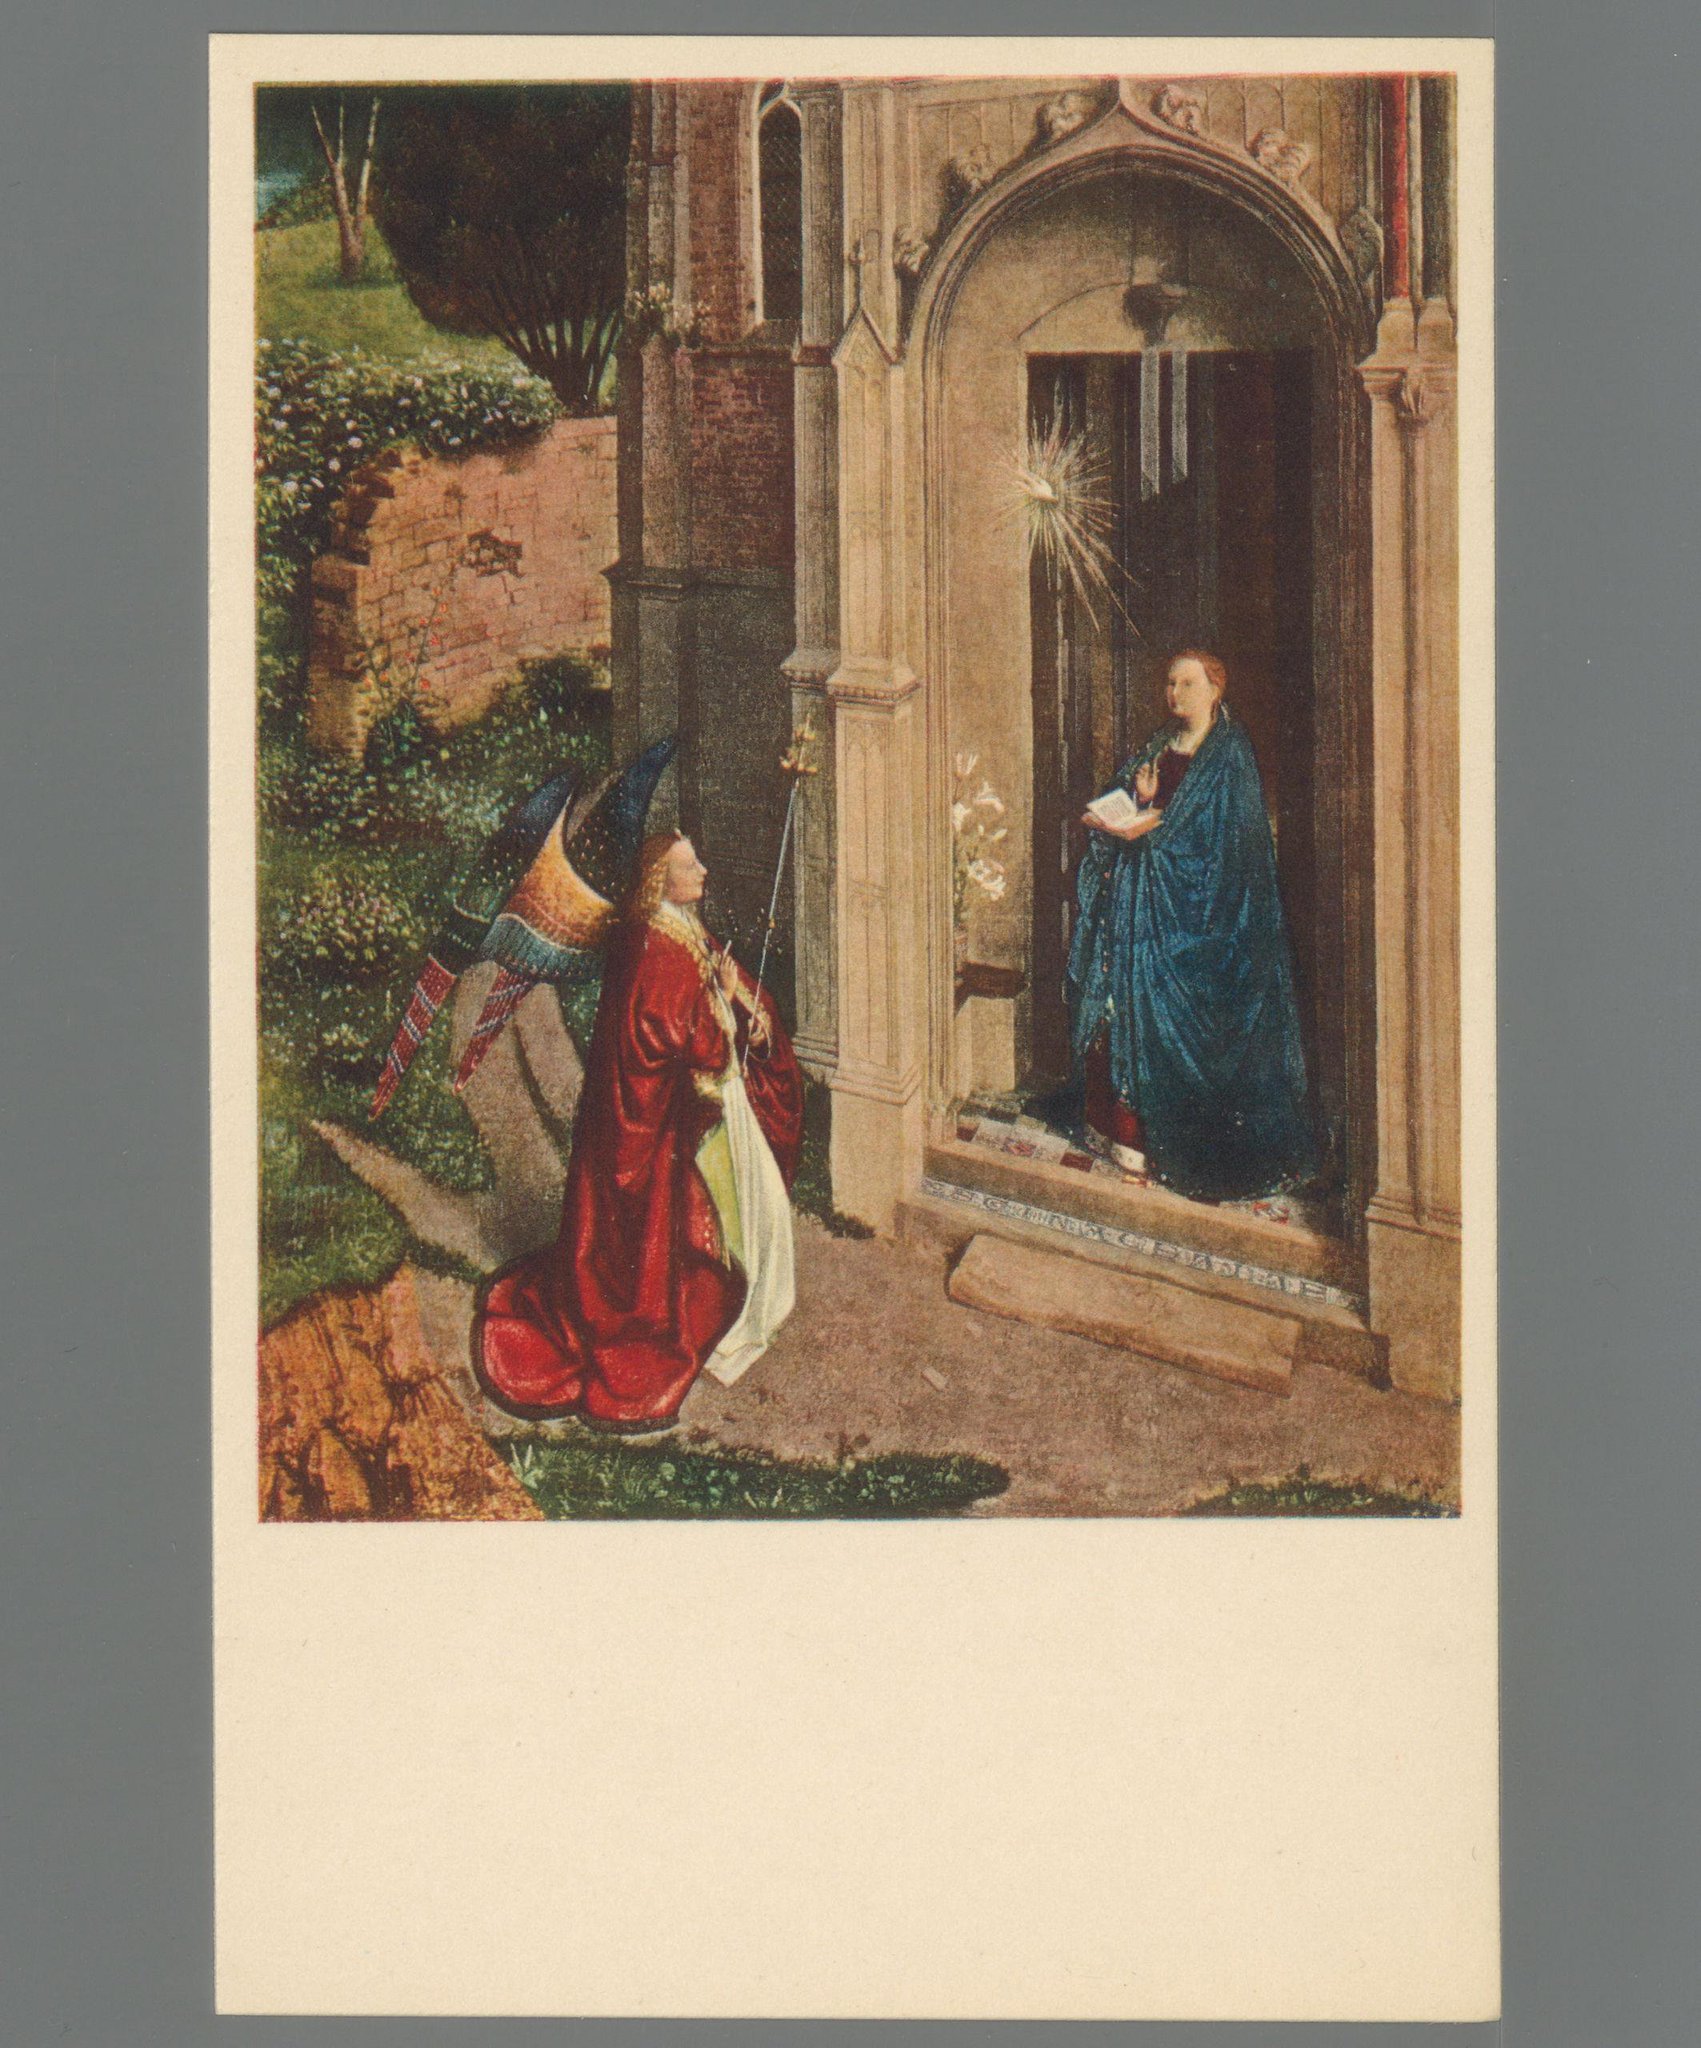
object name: ansichtkaart, prentbriefkaart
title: The Annunciation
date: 1932-1940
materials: cardboard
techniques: photograph, lithograph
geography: new york city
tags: the annunciation: mary standing, angels